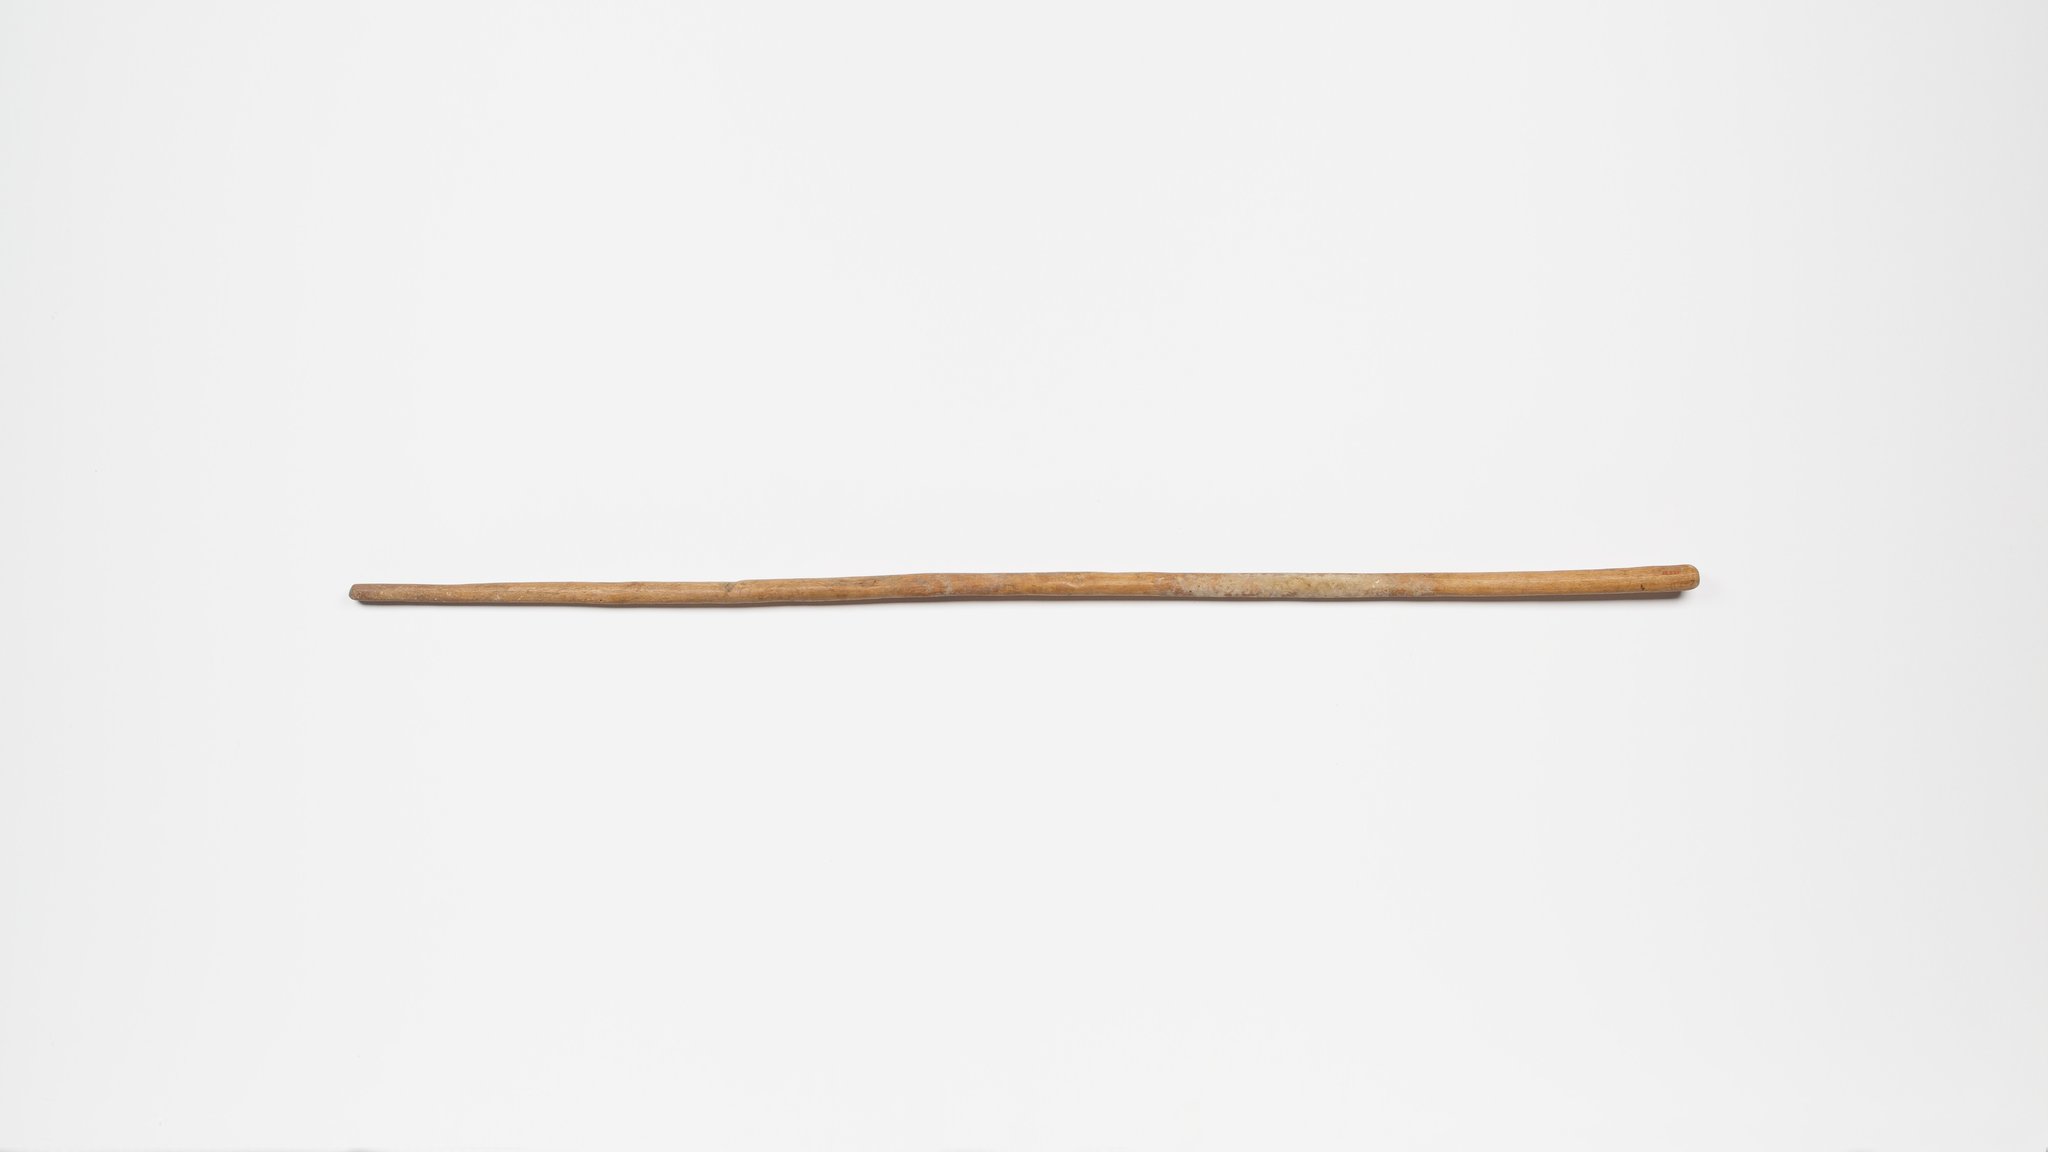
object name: staff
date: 2030-1640 BCE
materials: wood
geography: egypt